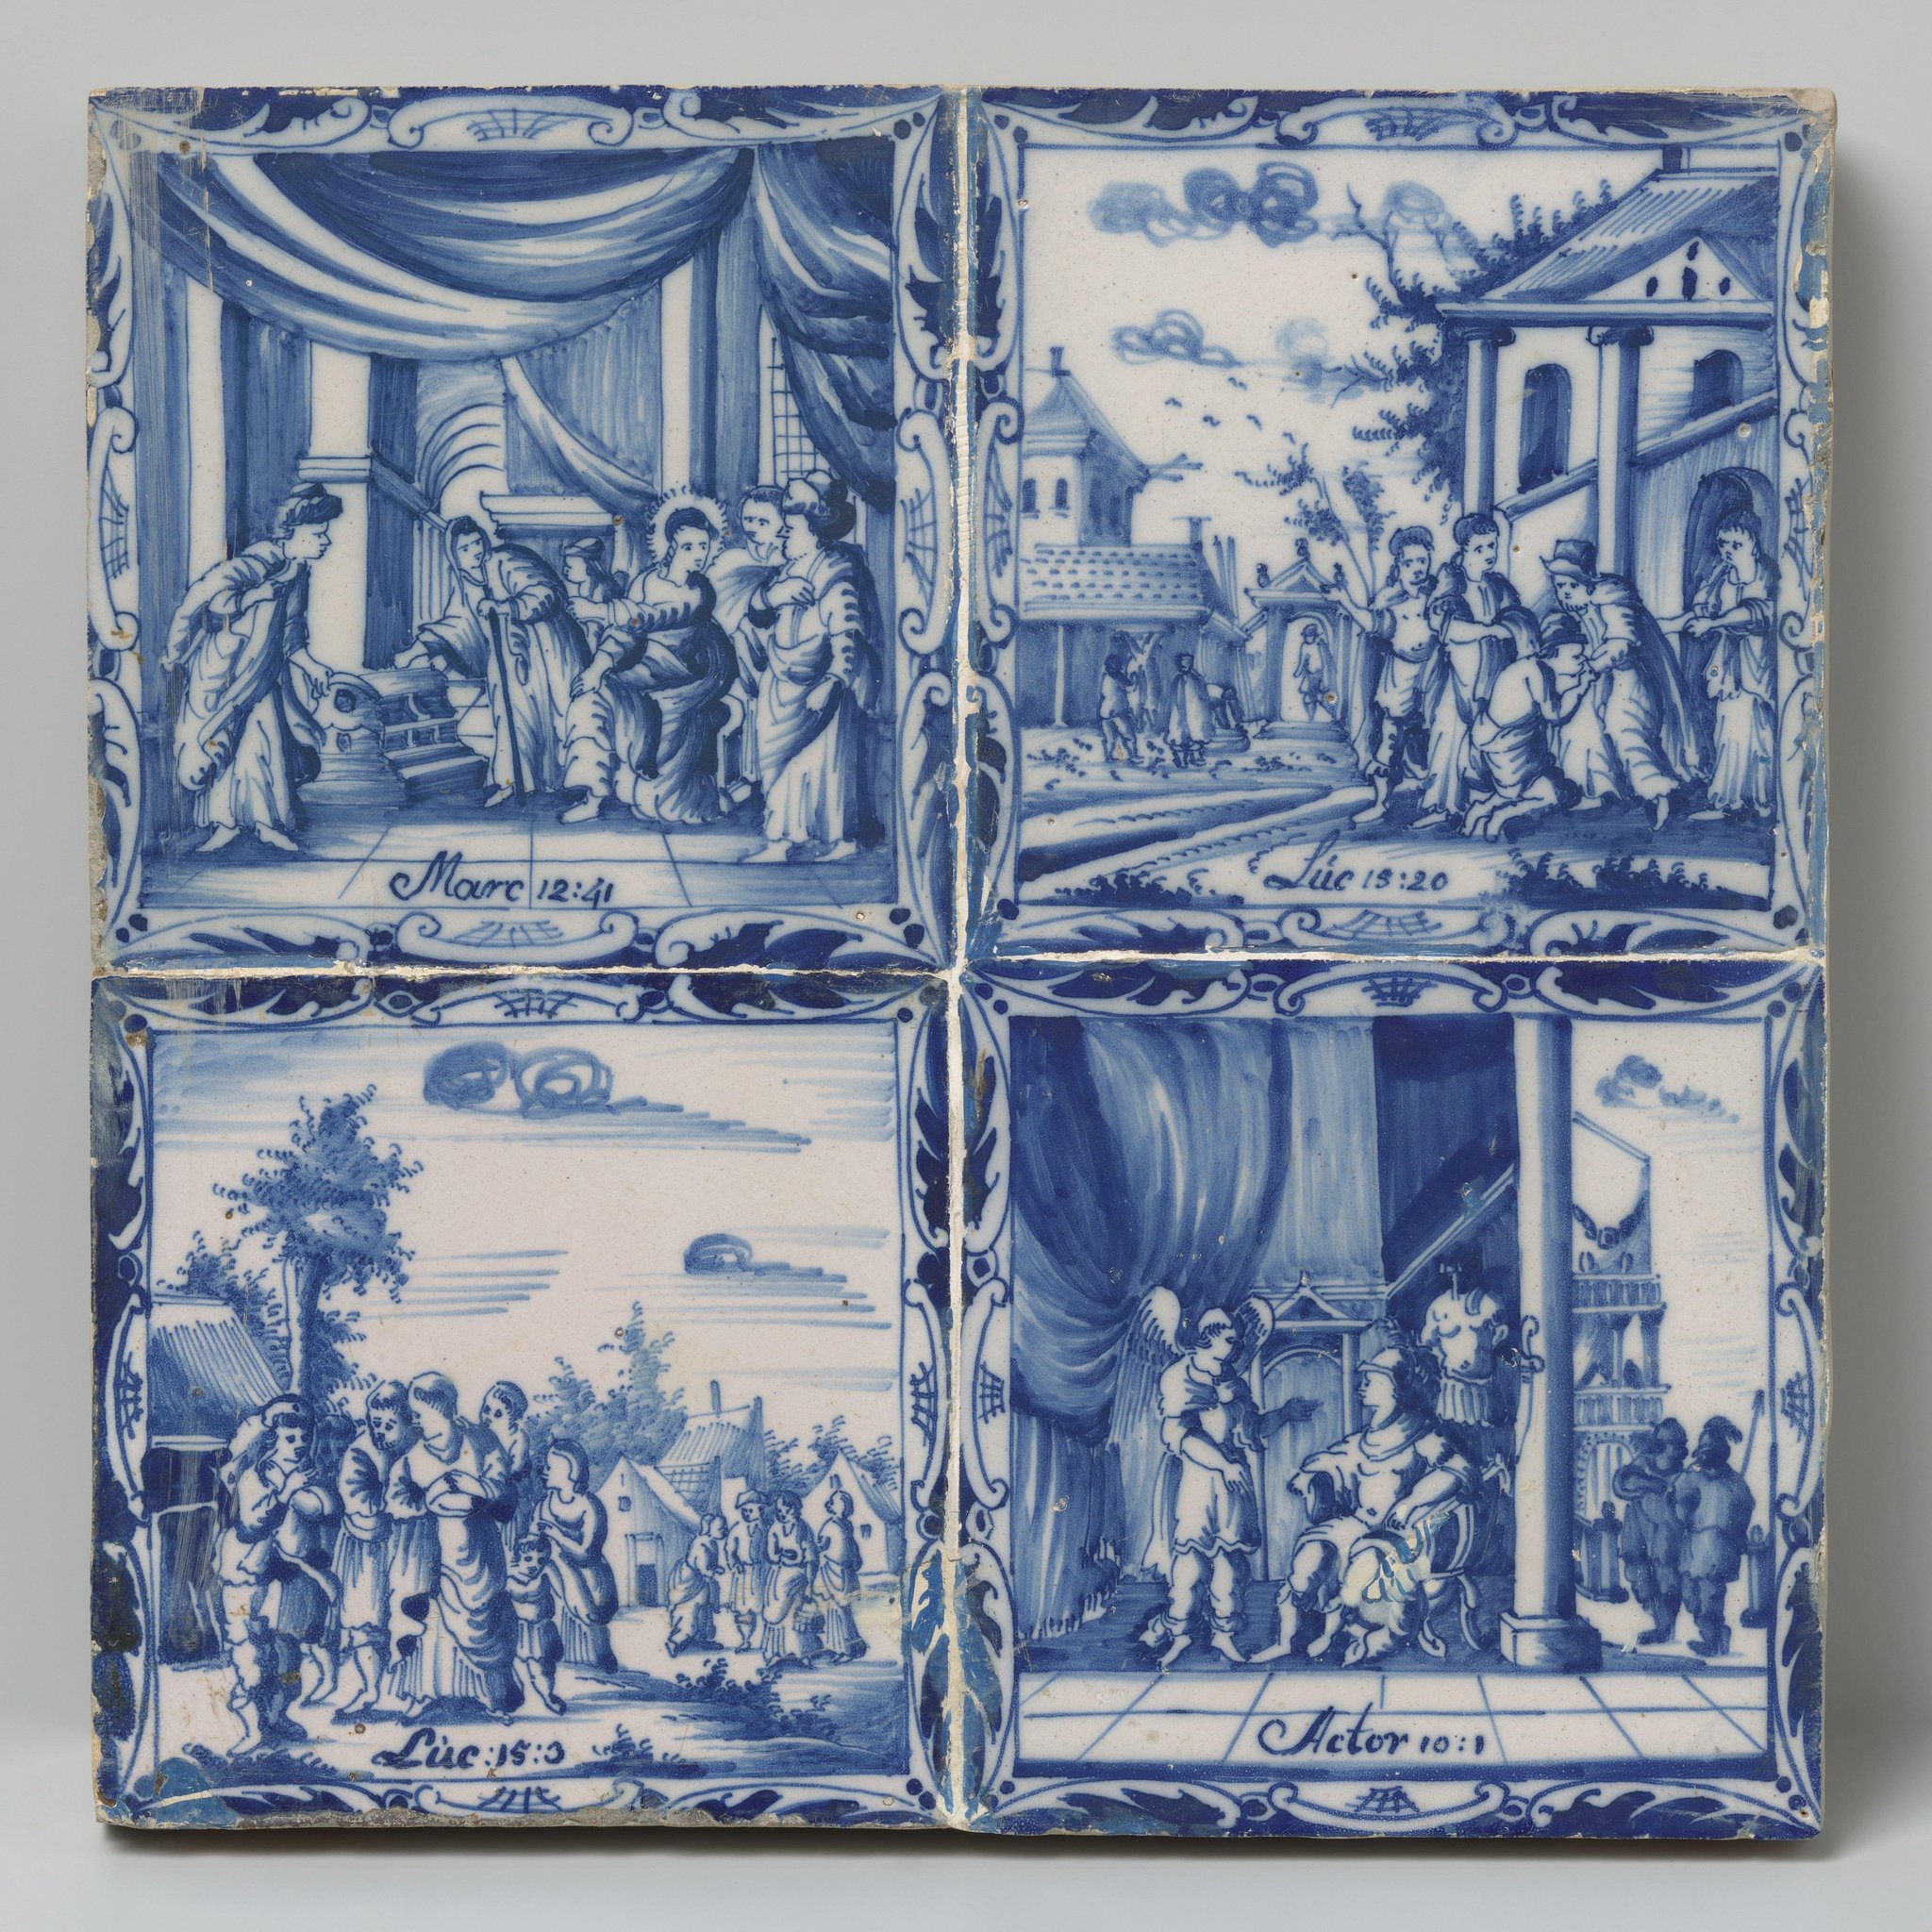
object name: tegelveld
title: Tegelveld met vier (twee x twee) tegels met bijbelse taferelen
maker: Anonymous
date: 1740-1780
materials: earthenware, glaze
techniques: maiolica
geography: netherlands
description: Tegelveld met vier (twee x twee) tegels met bijbelse taferelen: de penning van de arme weduwe, de parabel van het verloren schaap, de verloren zoon en het visioen van Cornelius.